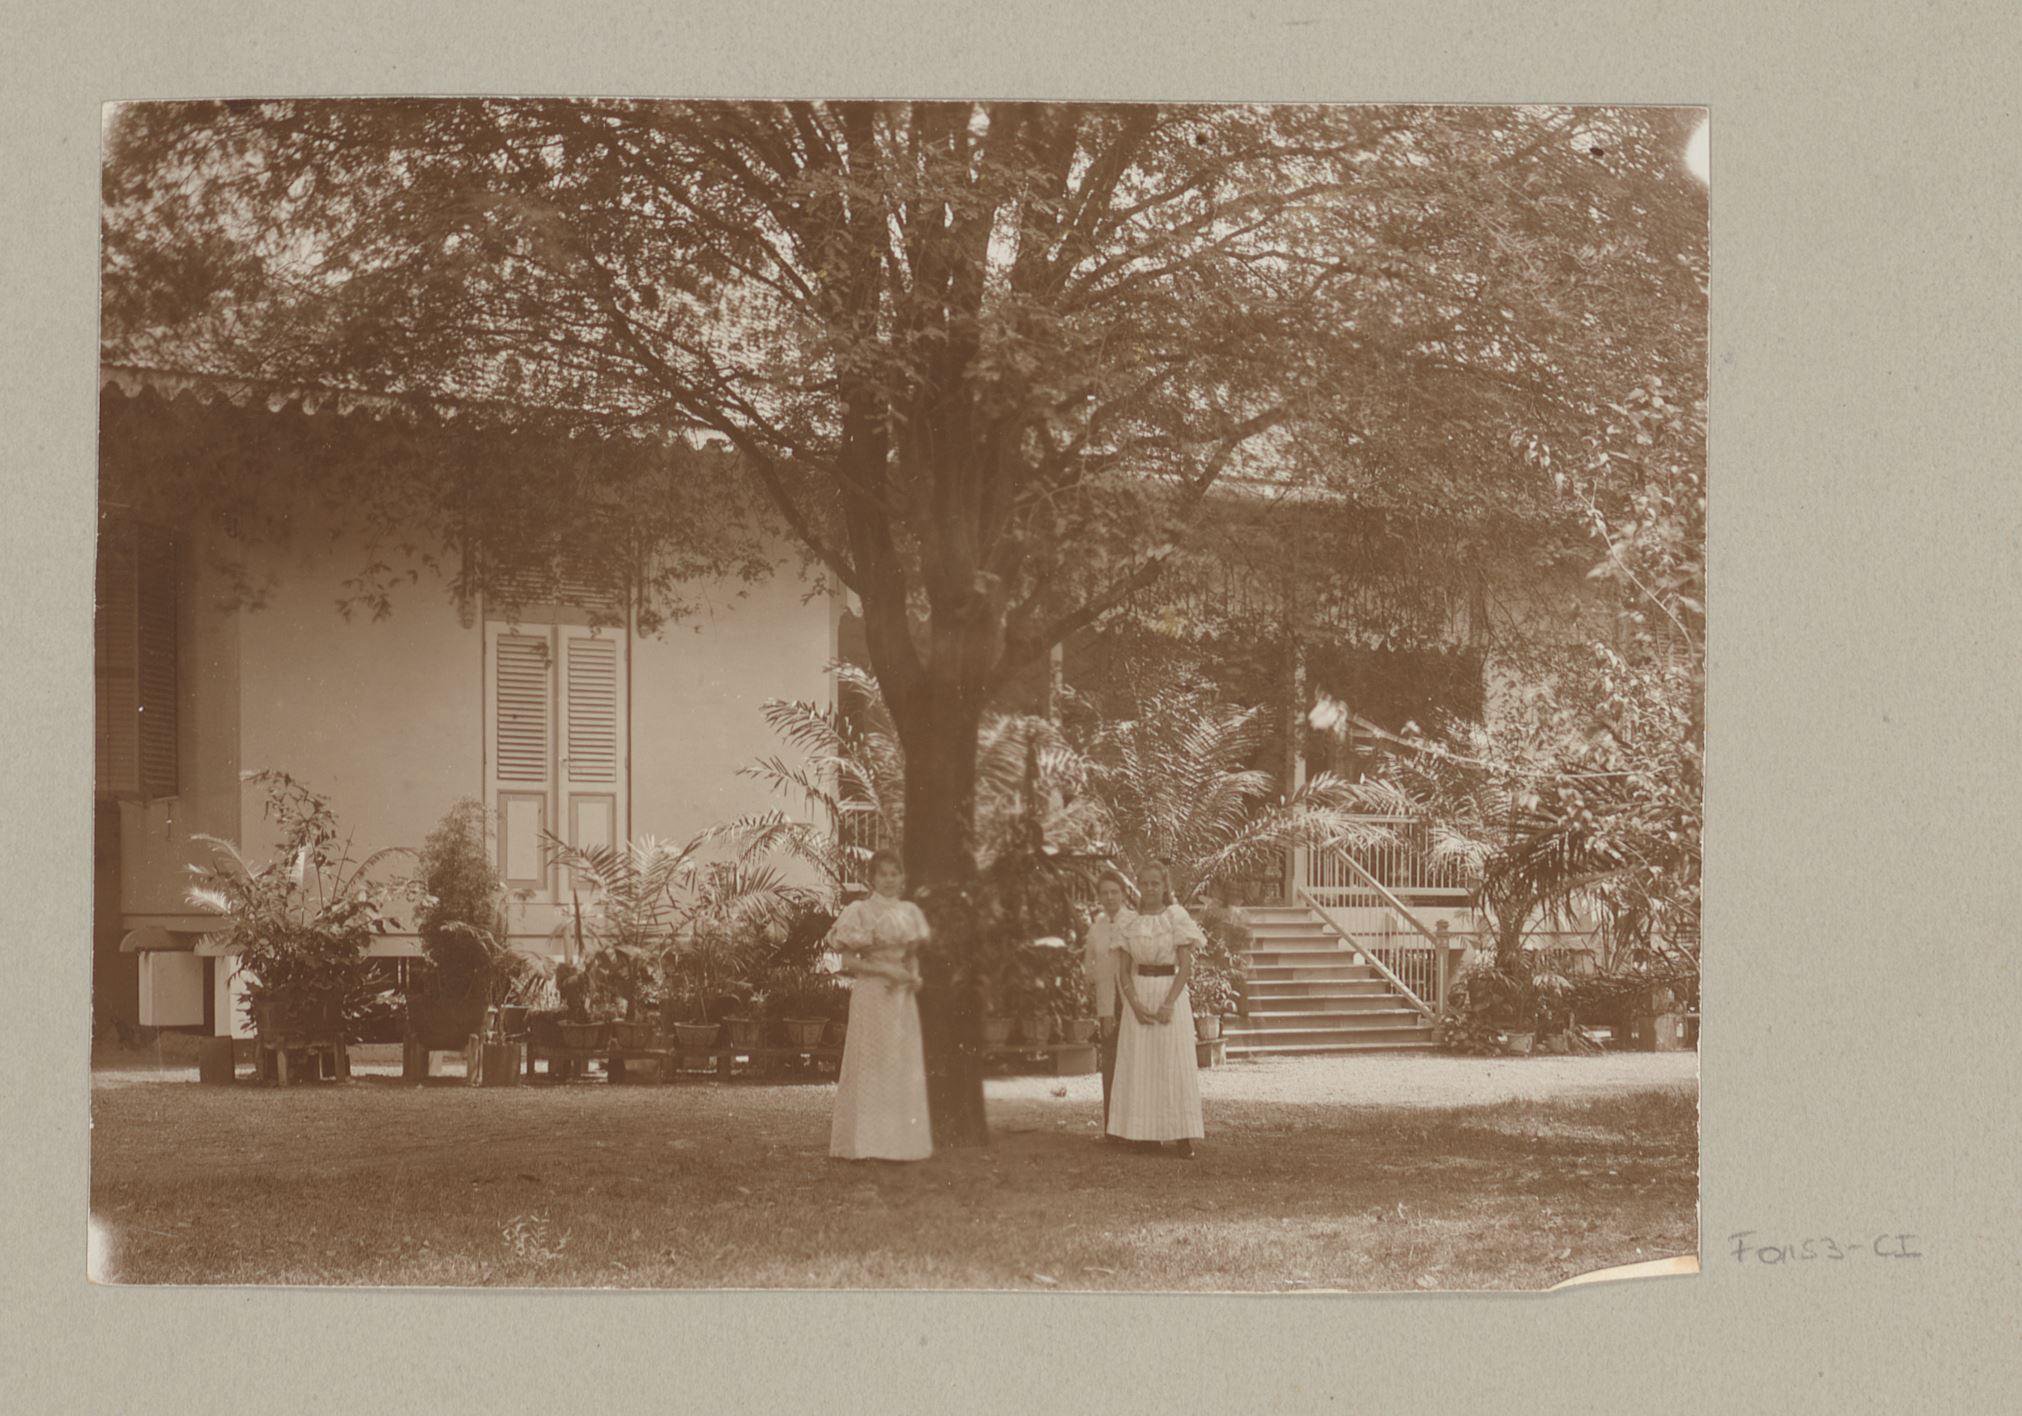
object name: photograph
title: Twee jonge vrouwen voor een woning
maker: Anonymous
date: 1890-1910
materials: photographic support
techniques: collodion silver print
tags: adolescent, young woman, maiden, rural housing, e.g. country-house, villa, cottage, dutch east indies, the